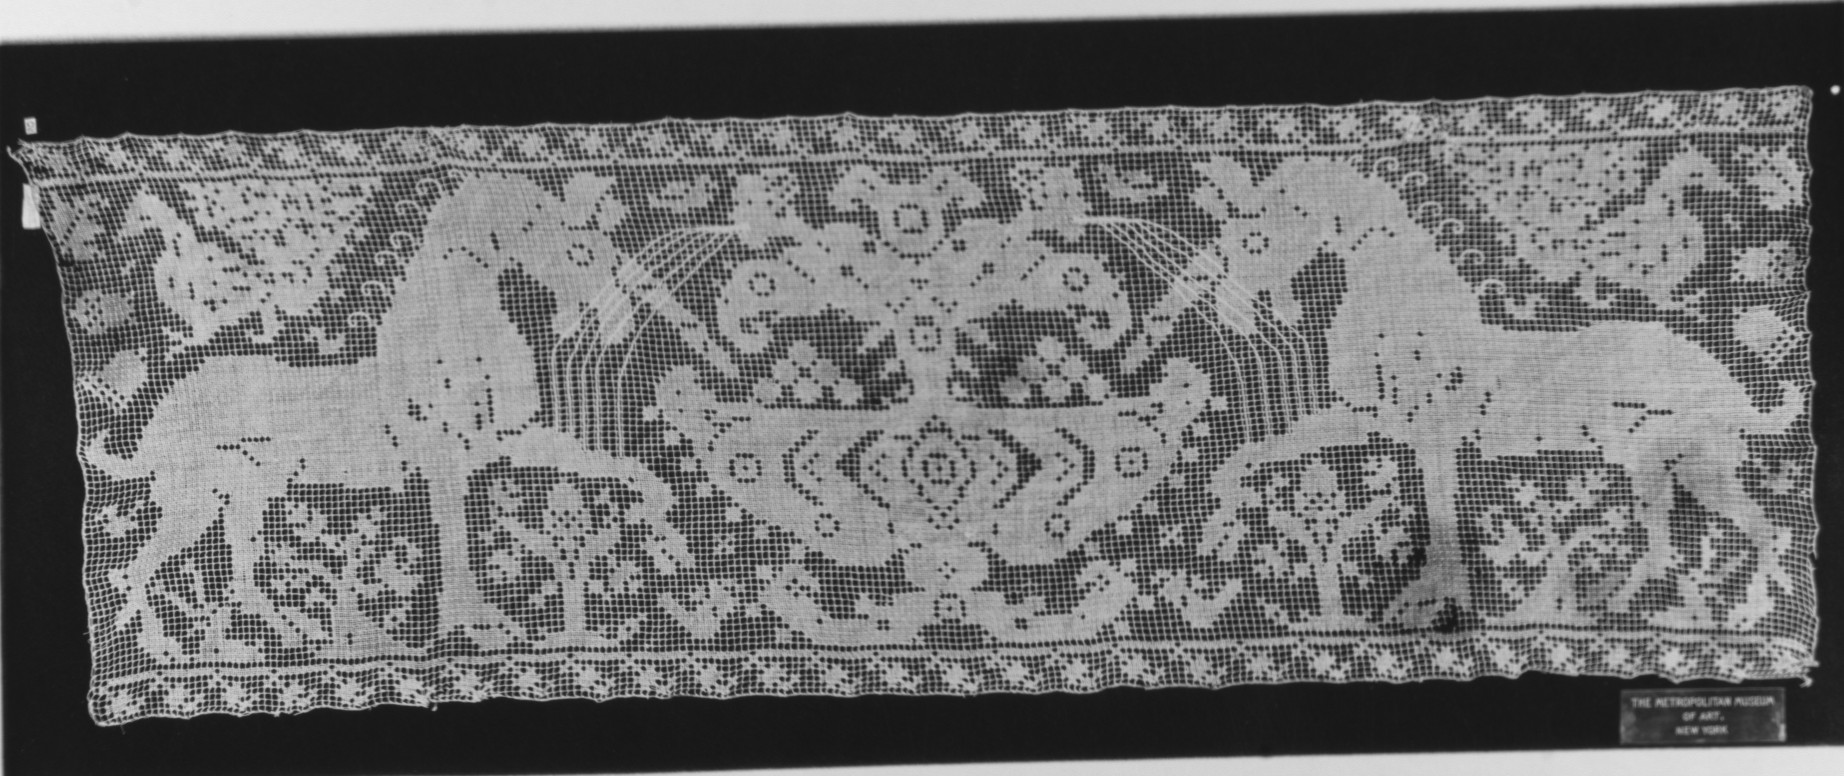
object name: border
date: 1501-1533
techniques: embroidery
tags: birds,fountains,unicorns